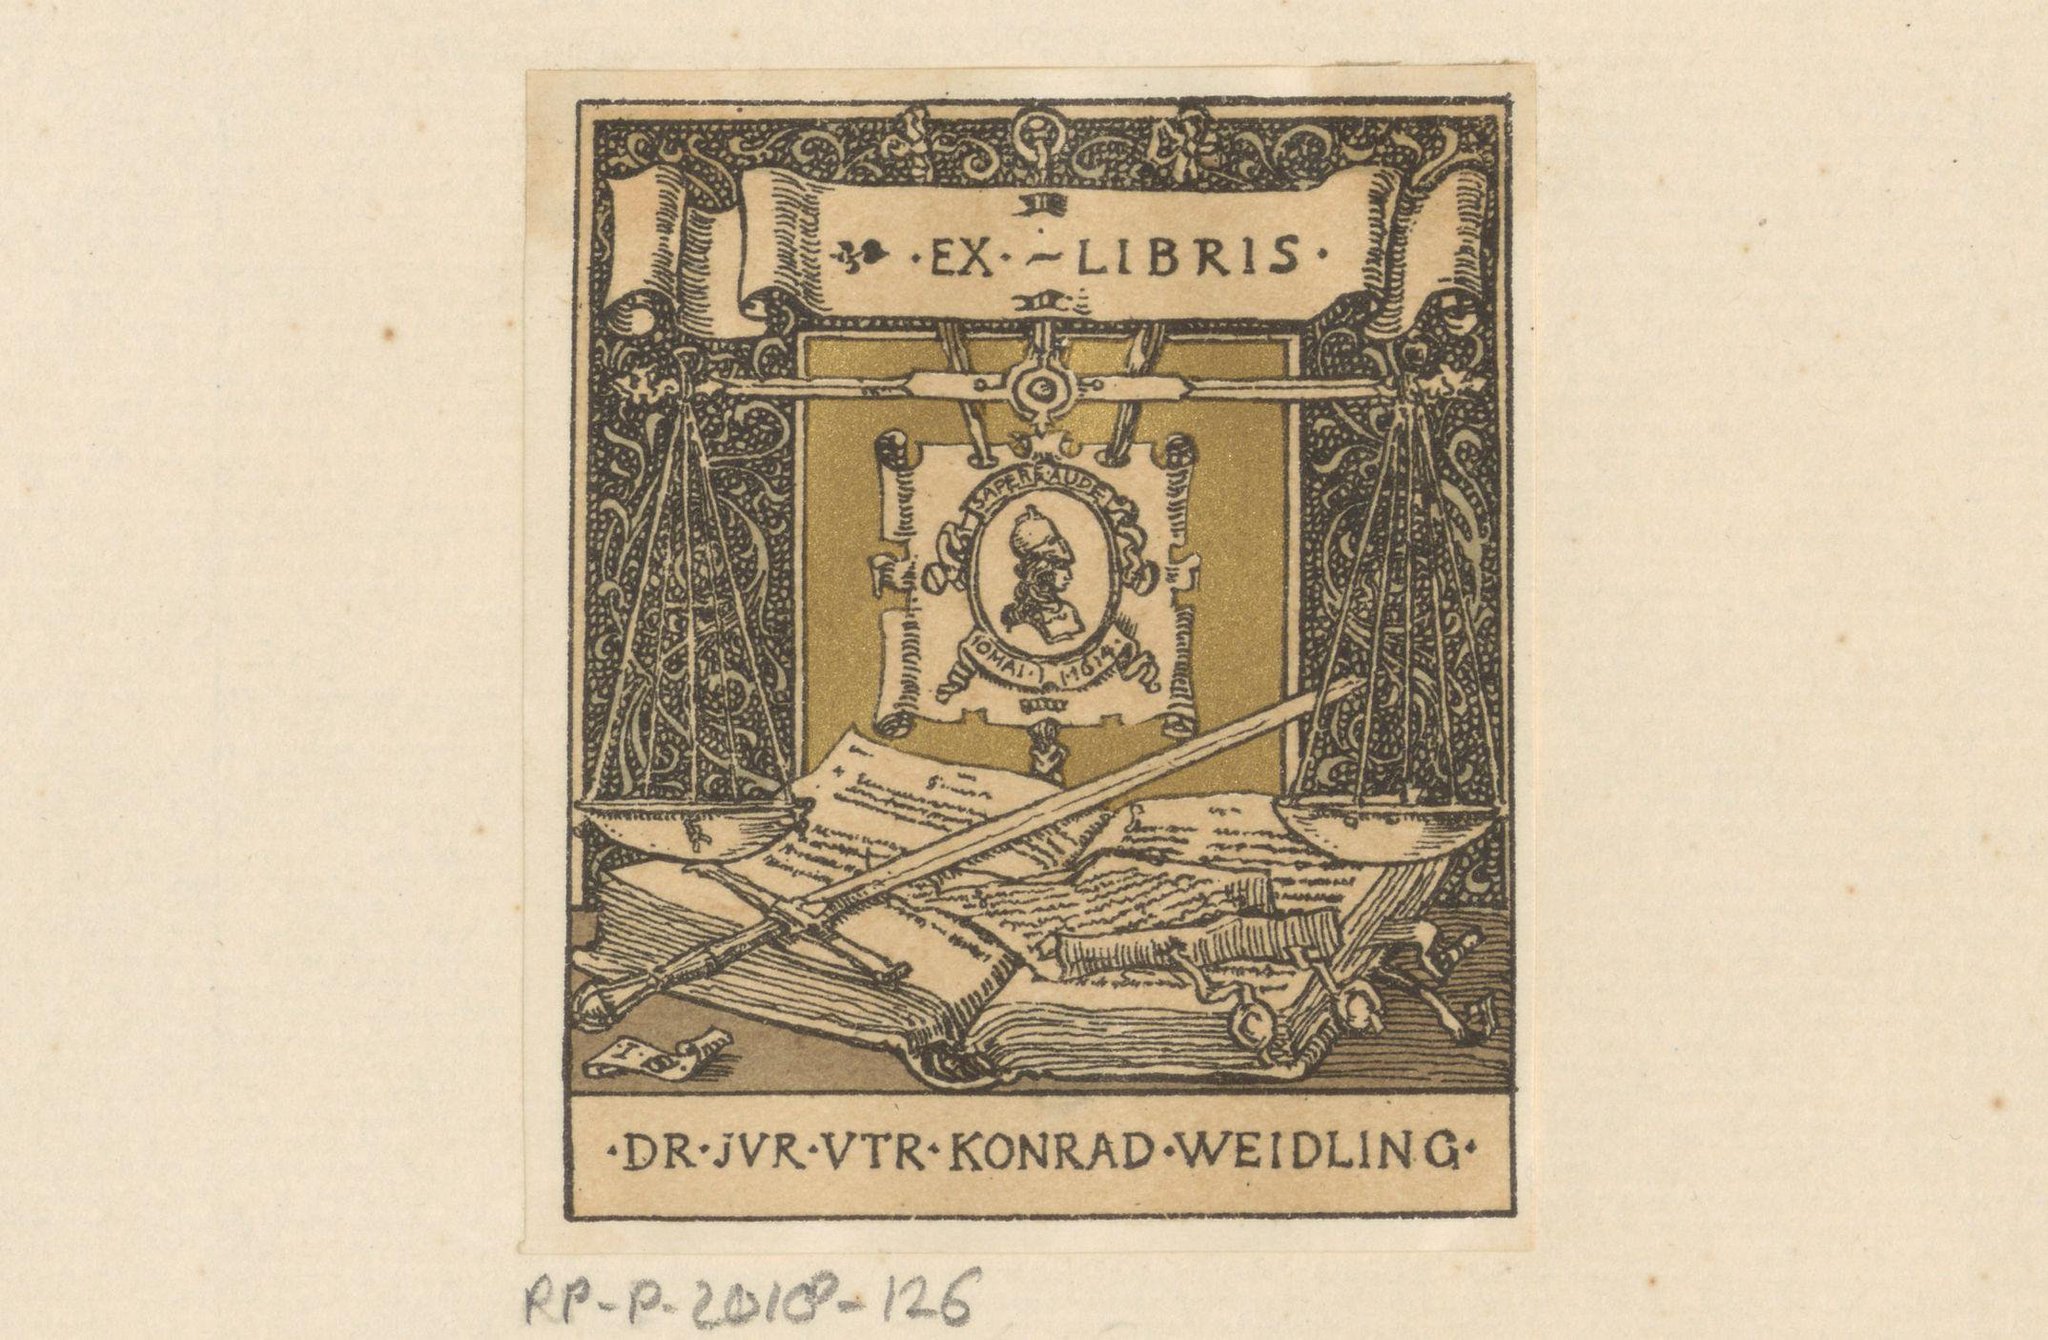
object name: bookplate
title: Ex-libris Dr. jur. utr. Konrad Weidling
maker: joseph sattler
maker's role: painter, print maker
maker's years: 1867-1931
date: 1877-1931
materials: paper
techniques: lithograph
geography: germany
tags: book, law and jurisprudence, weighing-instruments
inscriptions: collector's mark: Lugt 2760, collector's mark: Lugt 2233